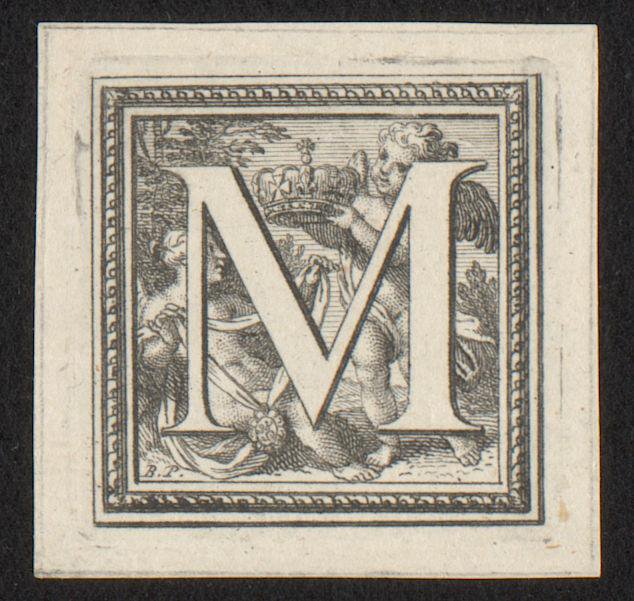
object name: book illustration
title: Initiaal M en putto met kroon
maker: bernard picart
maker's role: draughtsman, print maker, publisher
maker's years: 1673-1733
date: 1683-1733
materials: paper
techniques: engraving, etching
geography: amsterdam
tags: crown (symbol of sovereignty), historiated initial, cupids: 'amores', 'amoretti', 'putti'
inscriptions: collector's mark: Lugt 240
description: Initiaal M met op de achtergrond een putto met een kroon en een naakte vrouw met een sjerp met rozet.